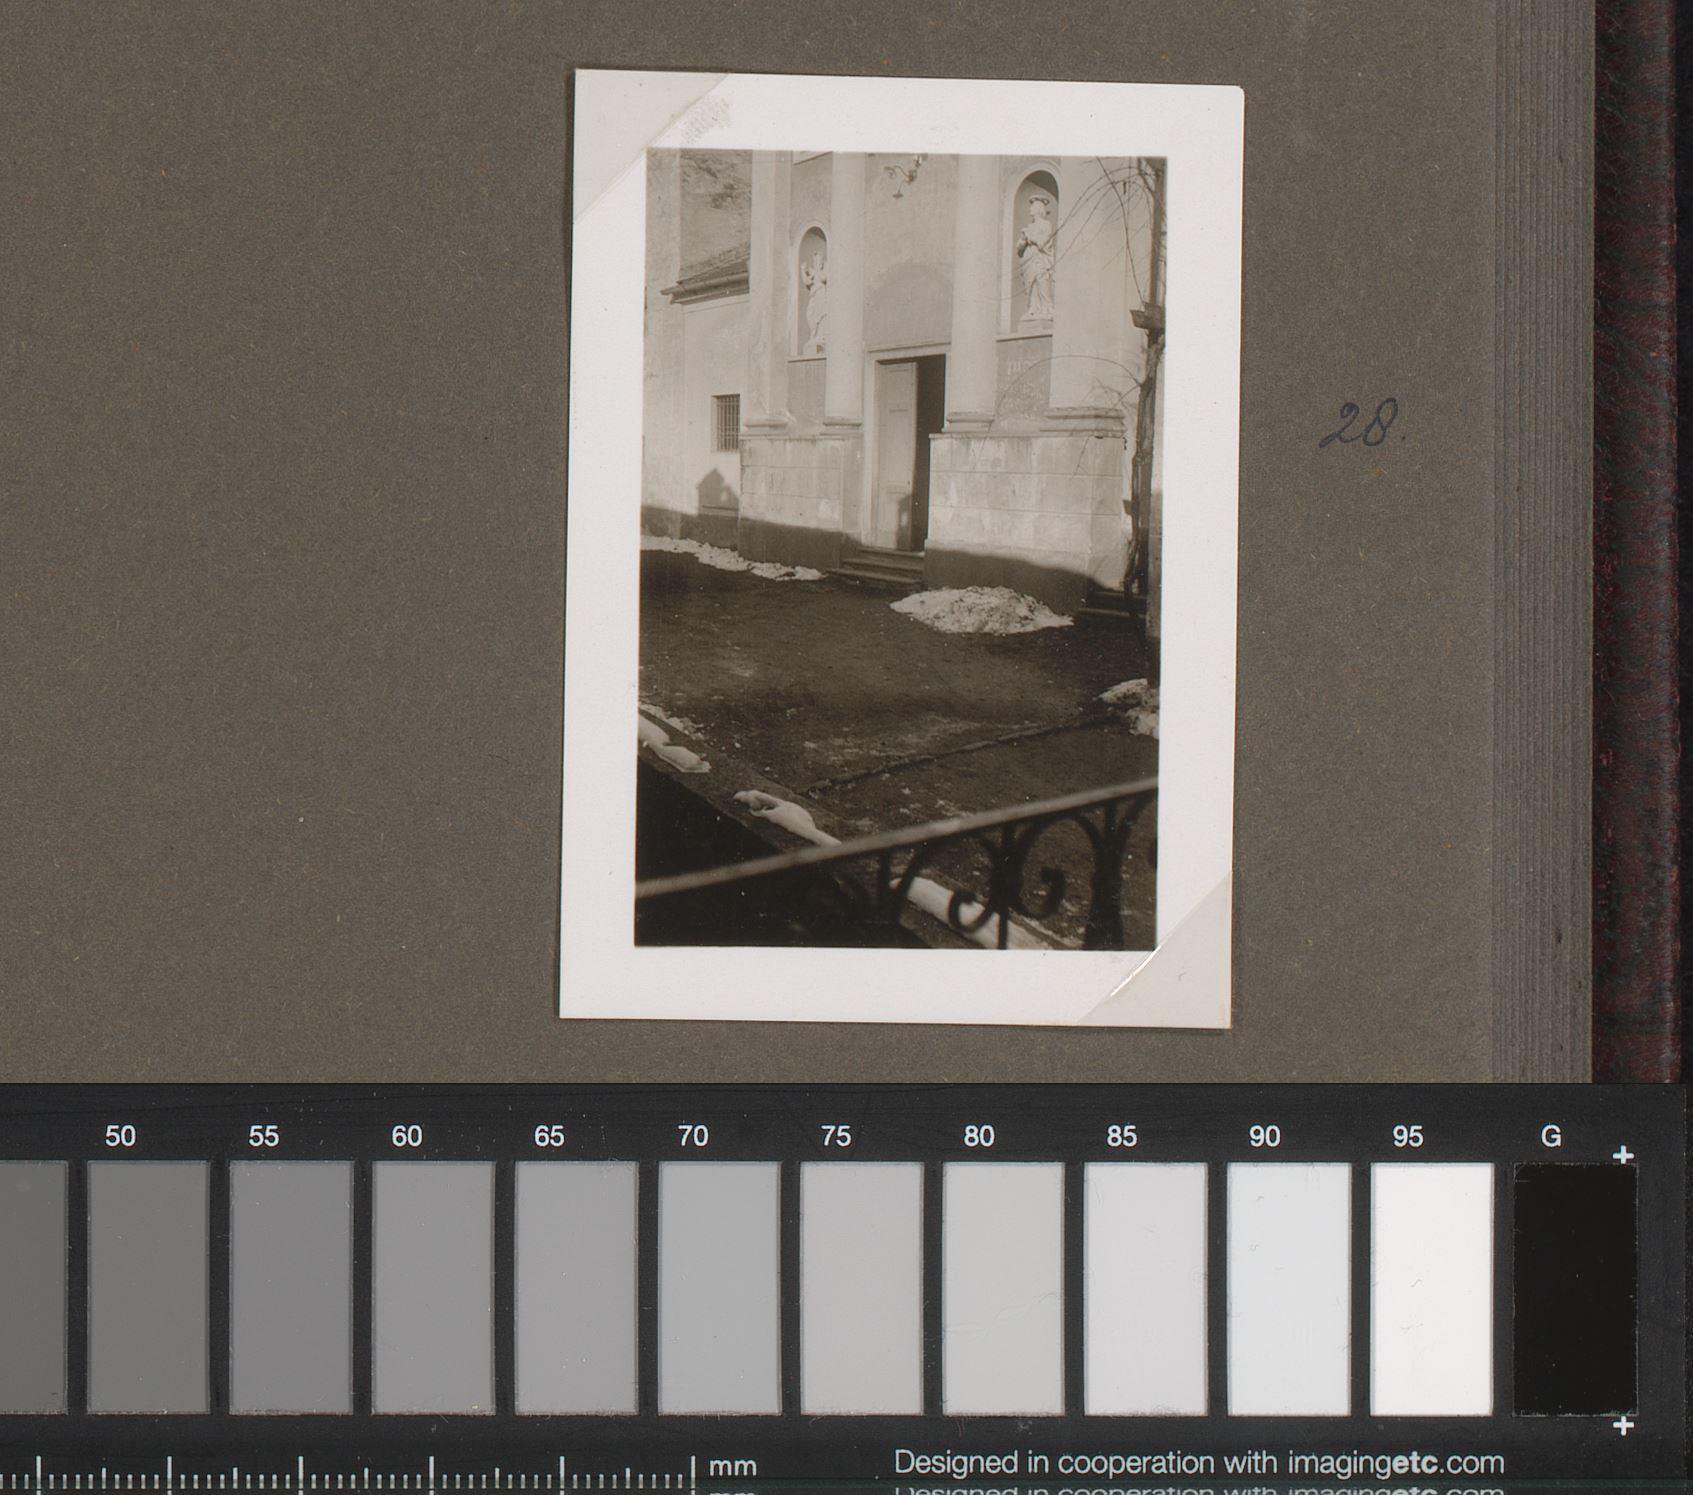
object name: album leaf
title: Portaal van de S. Ambrogio van Ponte Capriasca, Zwitserland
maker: Anonymous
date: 1933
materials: photographic support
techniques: gelatin silver print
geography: ponte capriasca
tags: parts of church exterior and annexes: portal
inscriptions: number: ‘27’, inscription: ‘waarin: copie van/ La Cena di Leonardo/ da Vinci (Milano)’